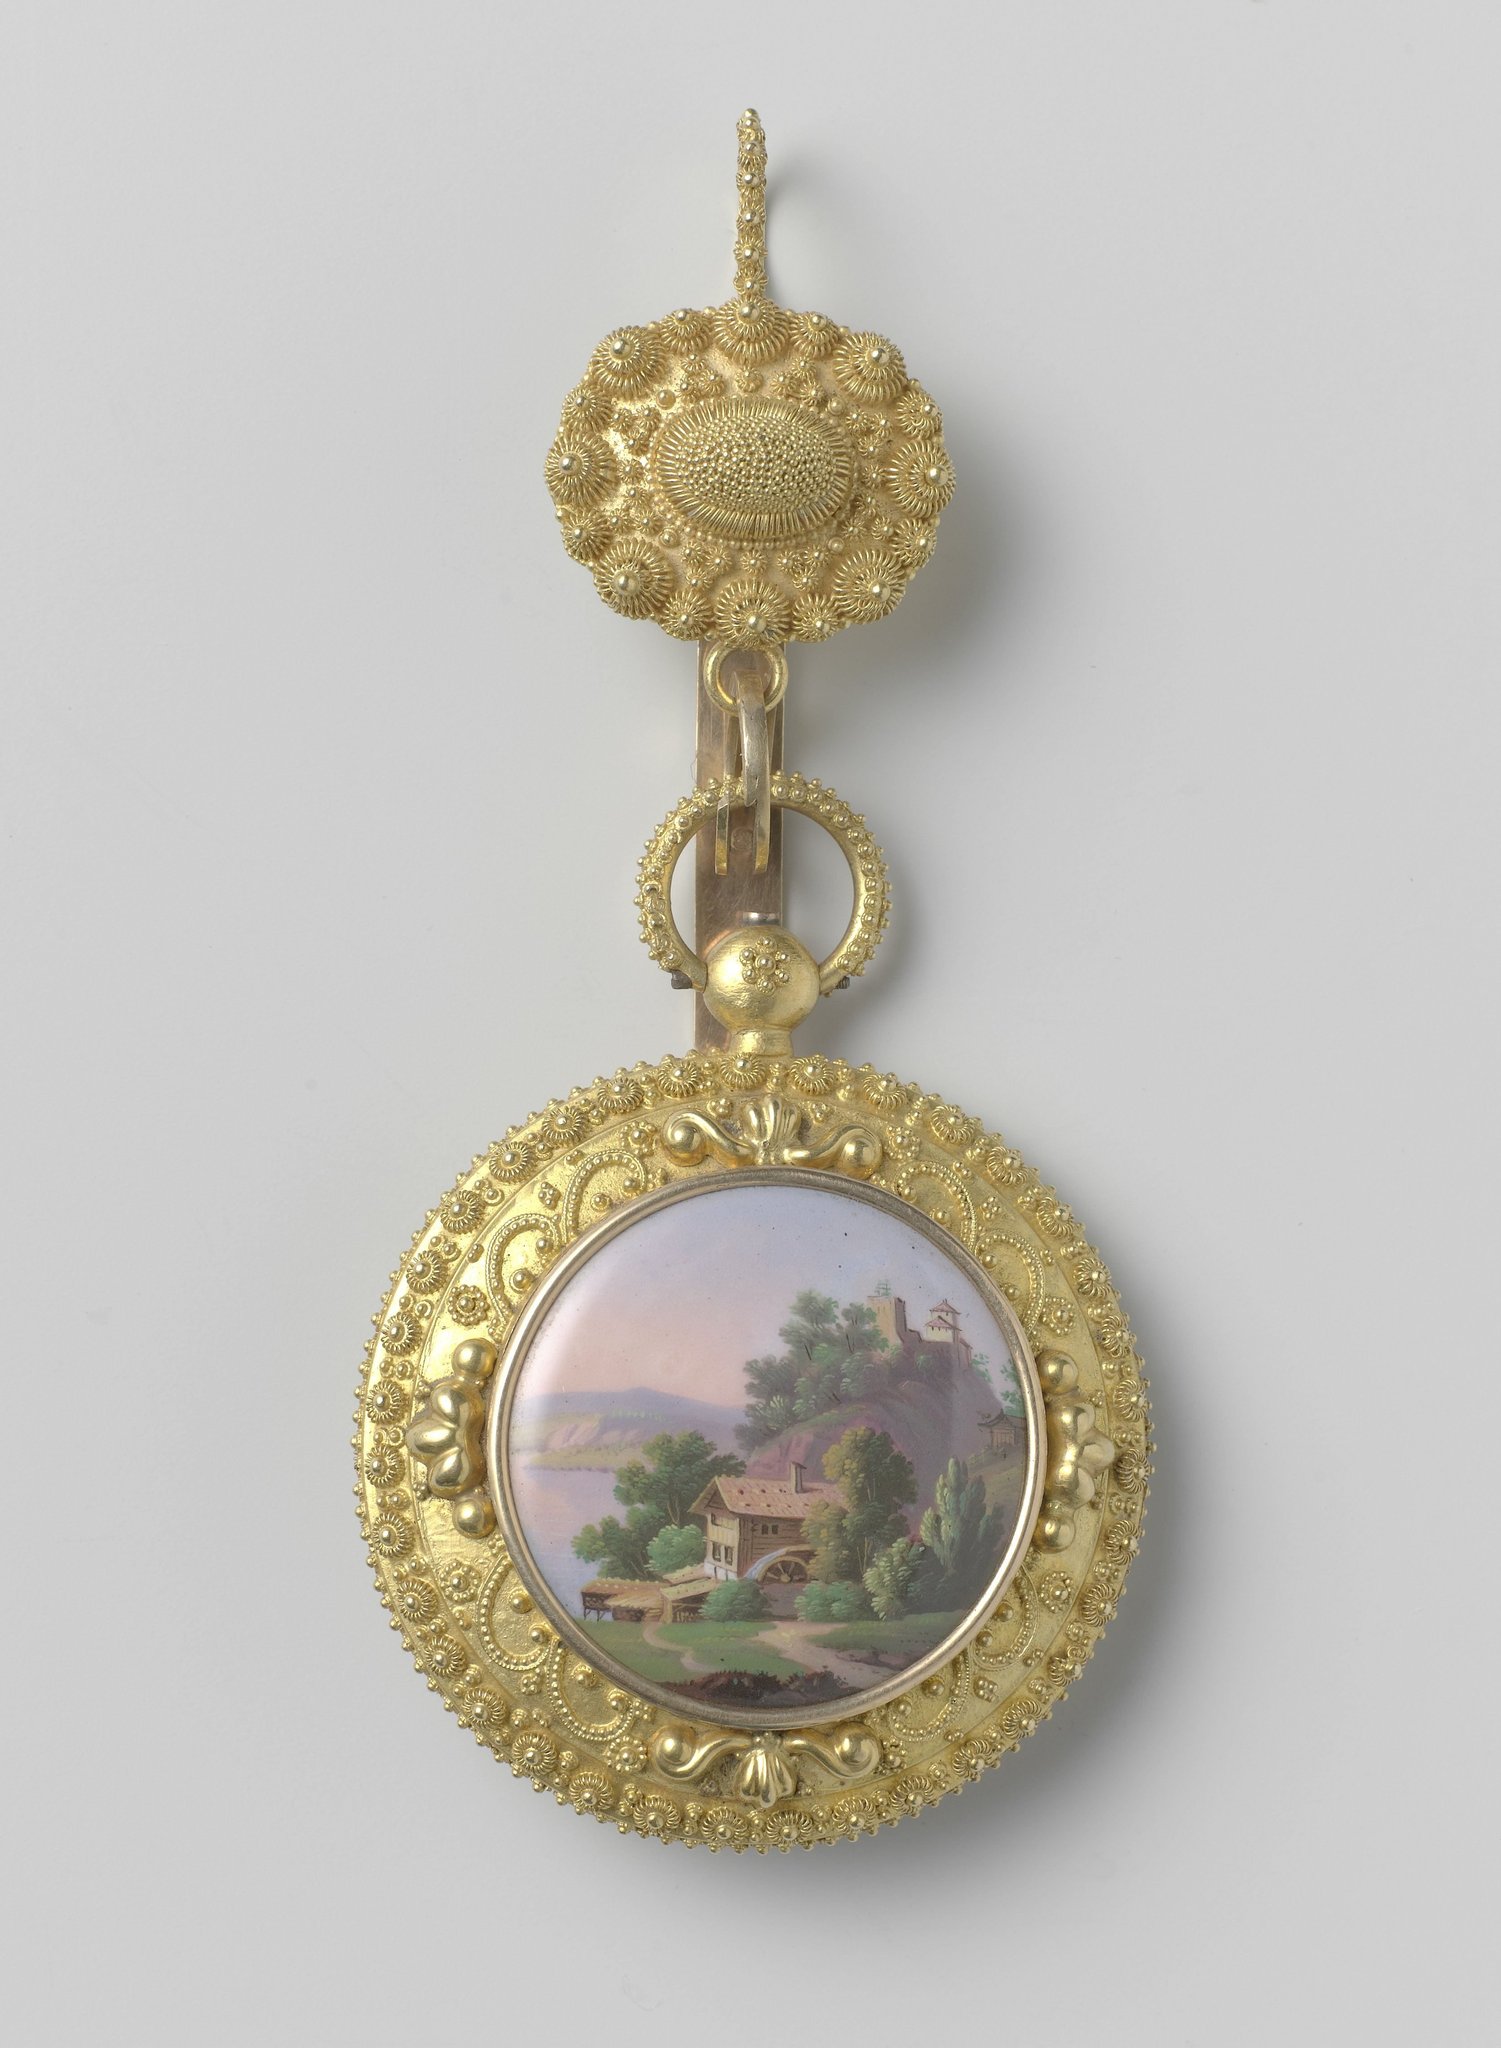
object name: jewellery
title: Horloge, versierd met Zwitsers berglandschap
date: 1815-1840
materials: gold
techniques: filigree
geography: switzerland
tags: watermill in landscape, mountains, switzerland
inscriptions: inscription: ‘8088’, maker's mark: ‘.I.I. of .T.T. in ruit’, maker's mark: ‘P&C’, alloy mark: ‘G (Genève, 1815-1881)’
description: Horloge van goud. De kast is versierd met een plaatje met een geëmailleerde voorstelling van een Zwitsers berglandschap.